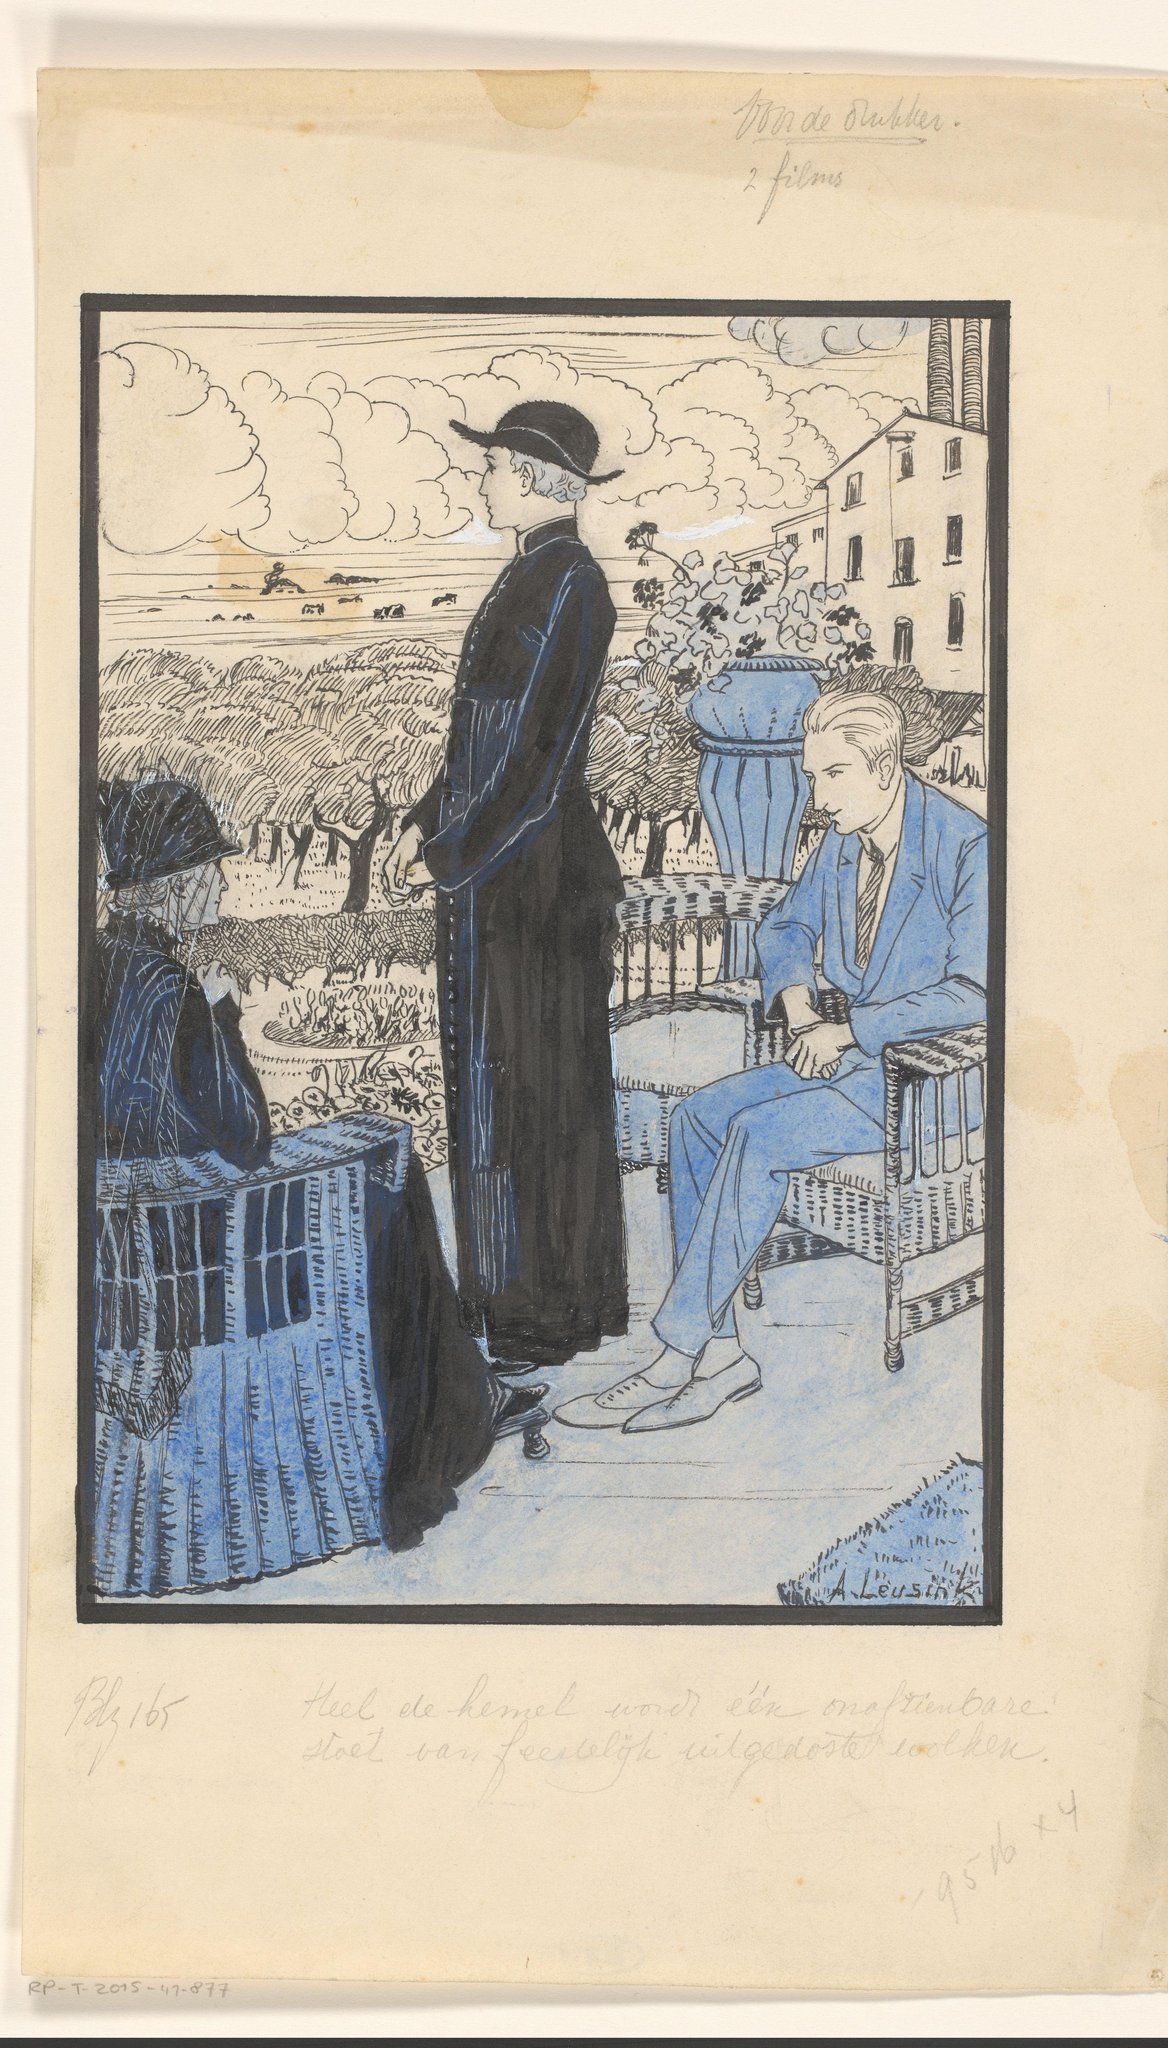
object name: drawing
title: Moeder, Rinus en Jan op het terras van een villa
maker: anny leusink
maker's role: draughtsman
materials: paint, ink, paper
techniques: brush, pen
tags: clouds, villa, terrace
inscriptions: annotation: ‘Blz 165 Heel de hemel wordt één onafzienbare/ stoet van feestelijk uitgedoste wolken.’, collector's mark: Lugt 2228, :, signature: ‘A Leusink’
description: Ontwerp voor: Koopmans, Marie. Deugniet, Durfniet en Dappere daden. Voor onze oudere knapen en meisjes. Amsterdam: Veen, 1926.